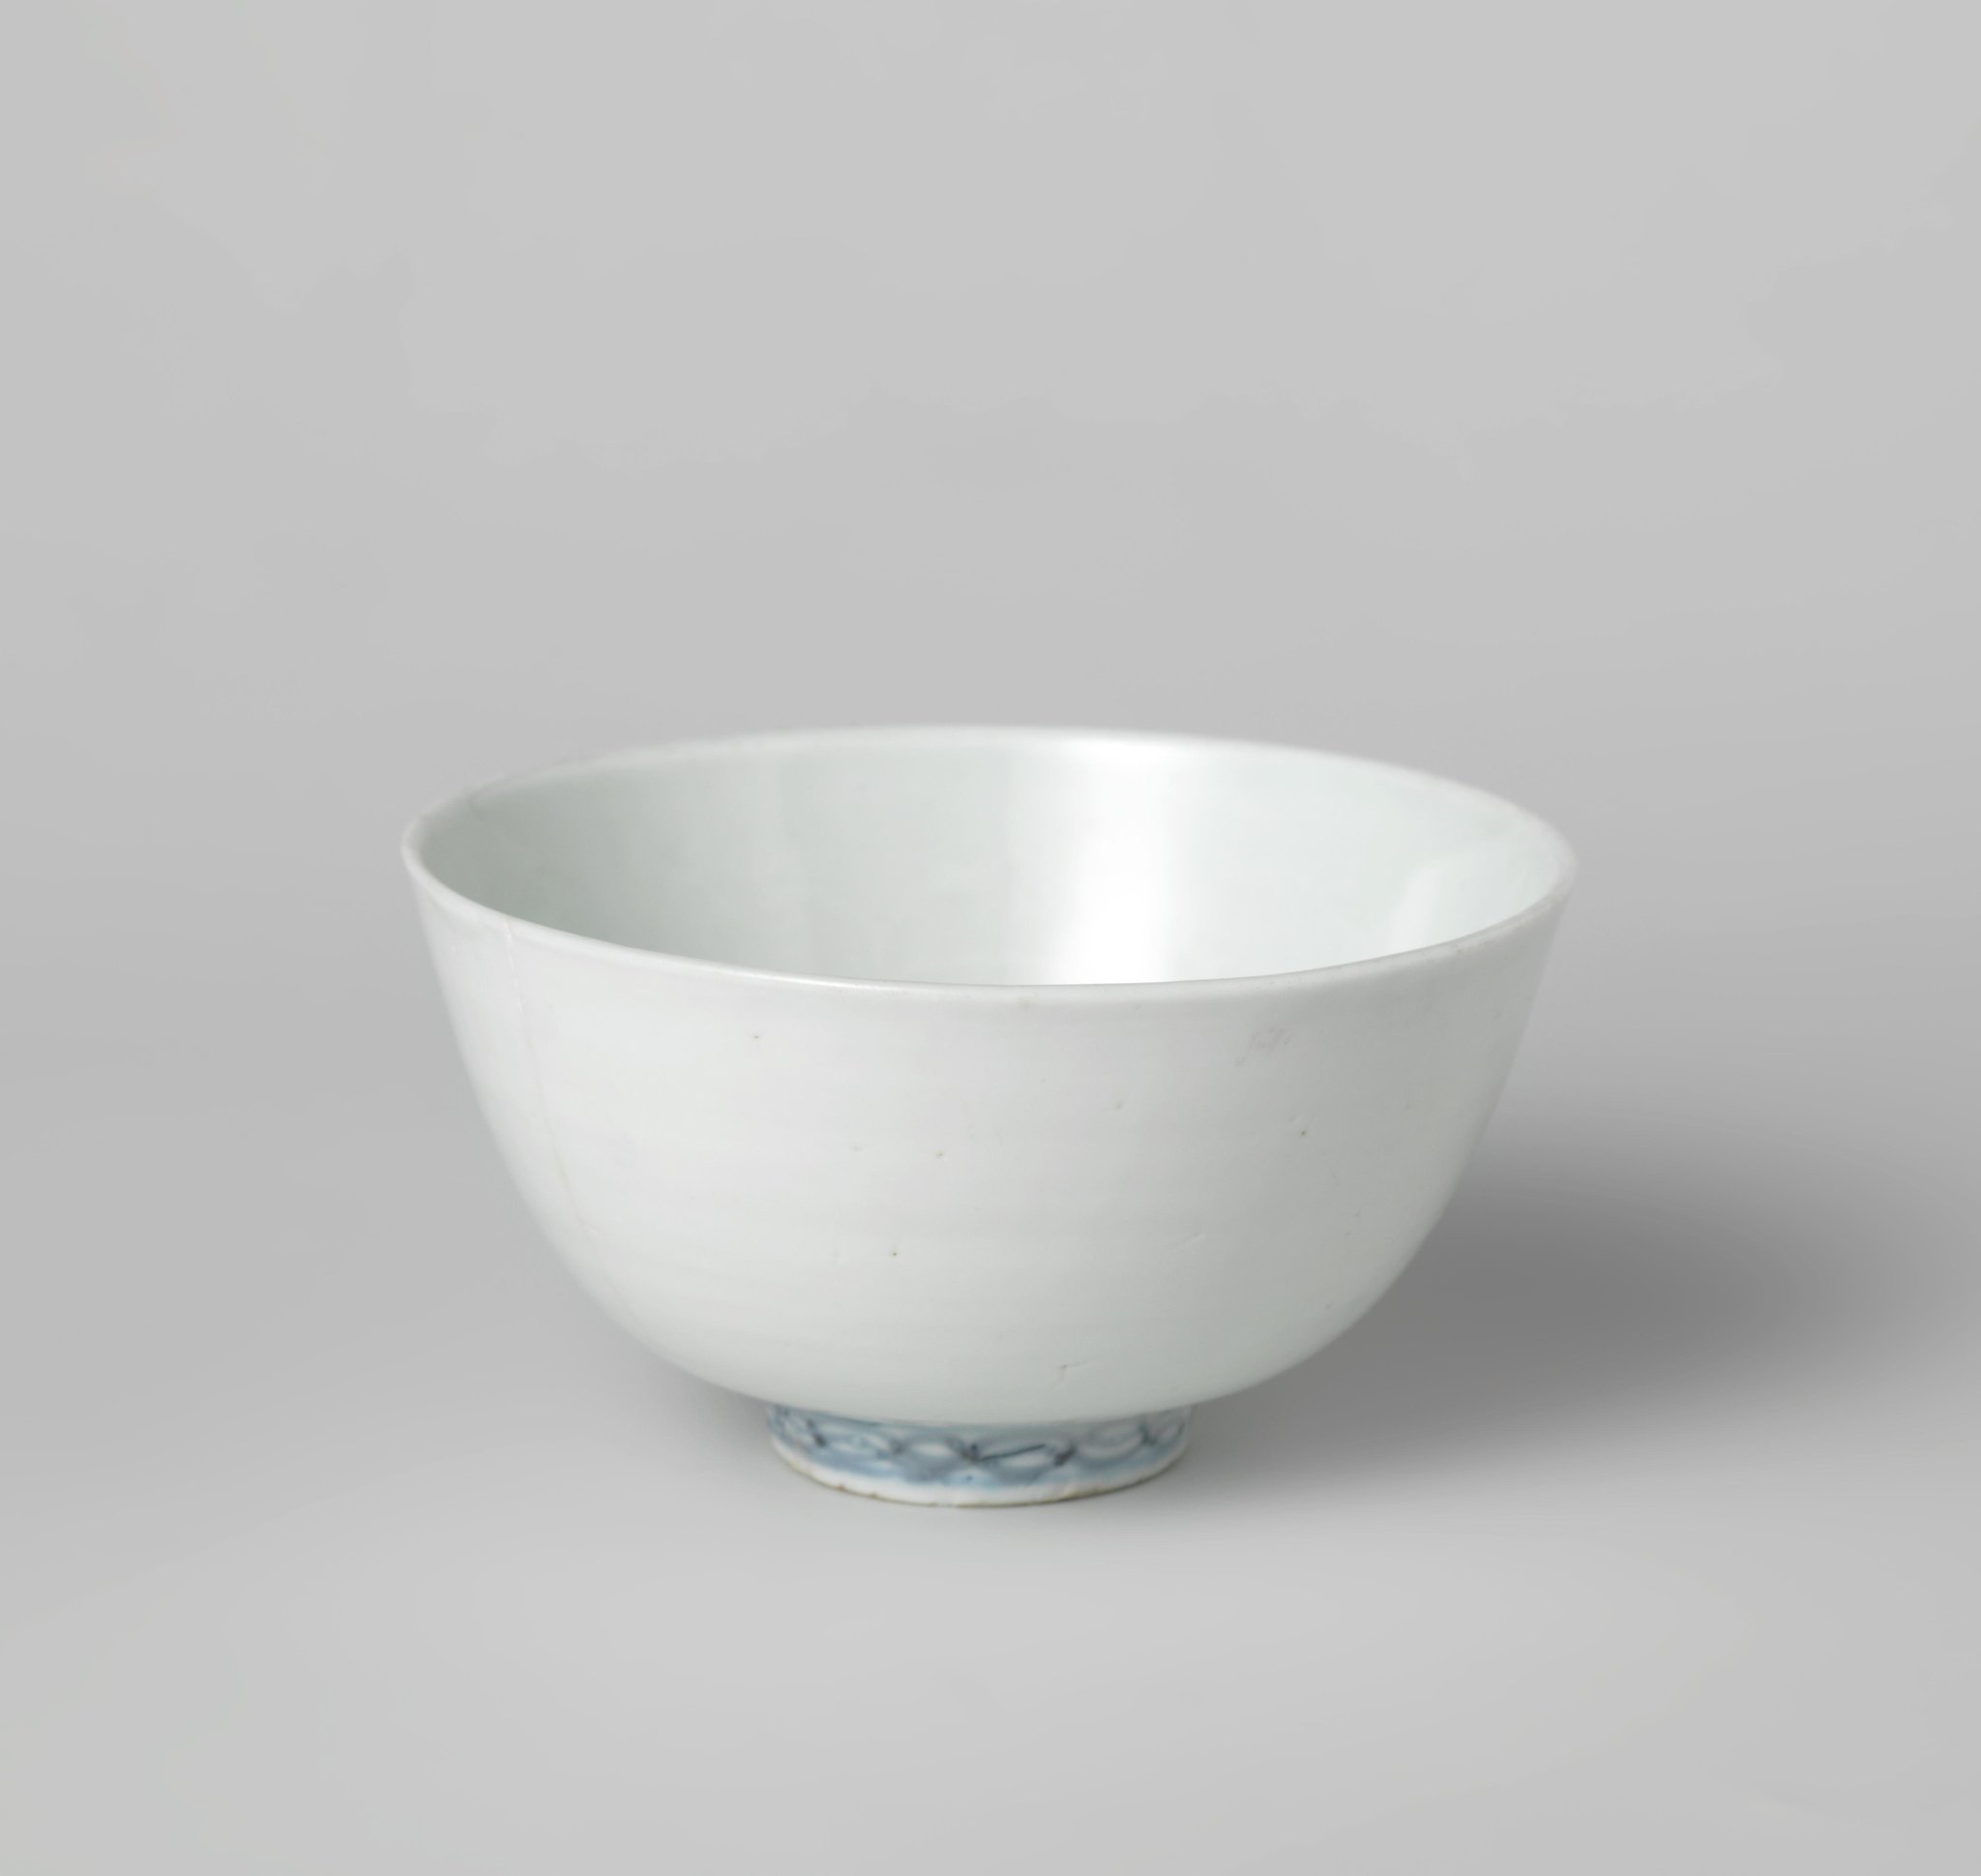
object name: tea bowl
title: Bowl with a crane among lotus plants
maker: Anonymous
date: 1500-1599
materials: cobalt, glaze, paint, porcelain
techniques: firing, turning, vitrification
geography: china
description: Kom bedekt met een lichtblauwachtige glazuur. Op het plat een versiering in onderglazuurblauw met een reiger. Mogelijk een theekom.